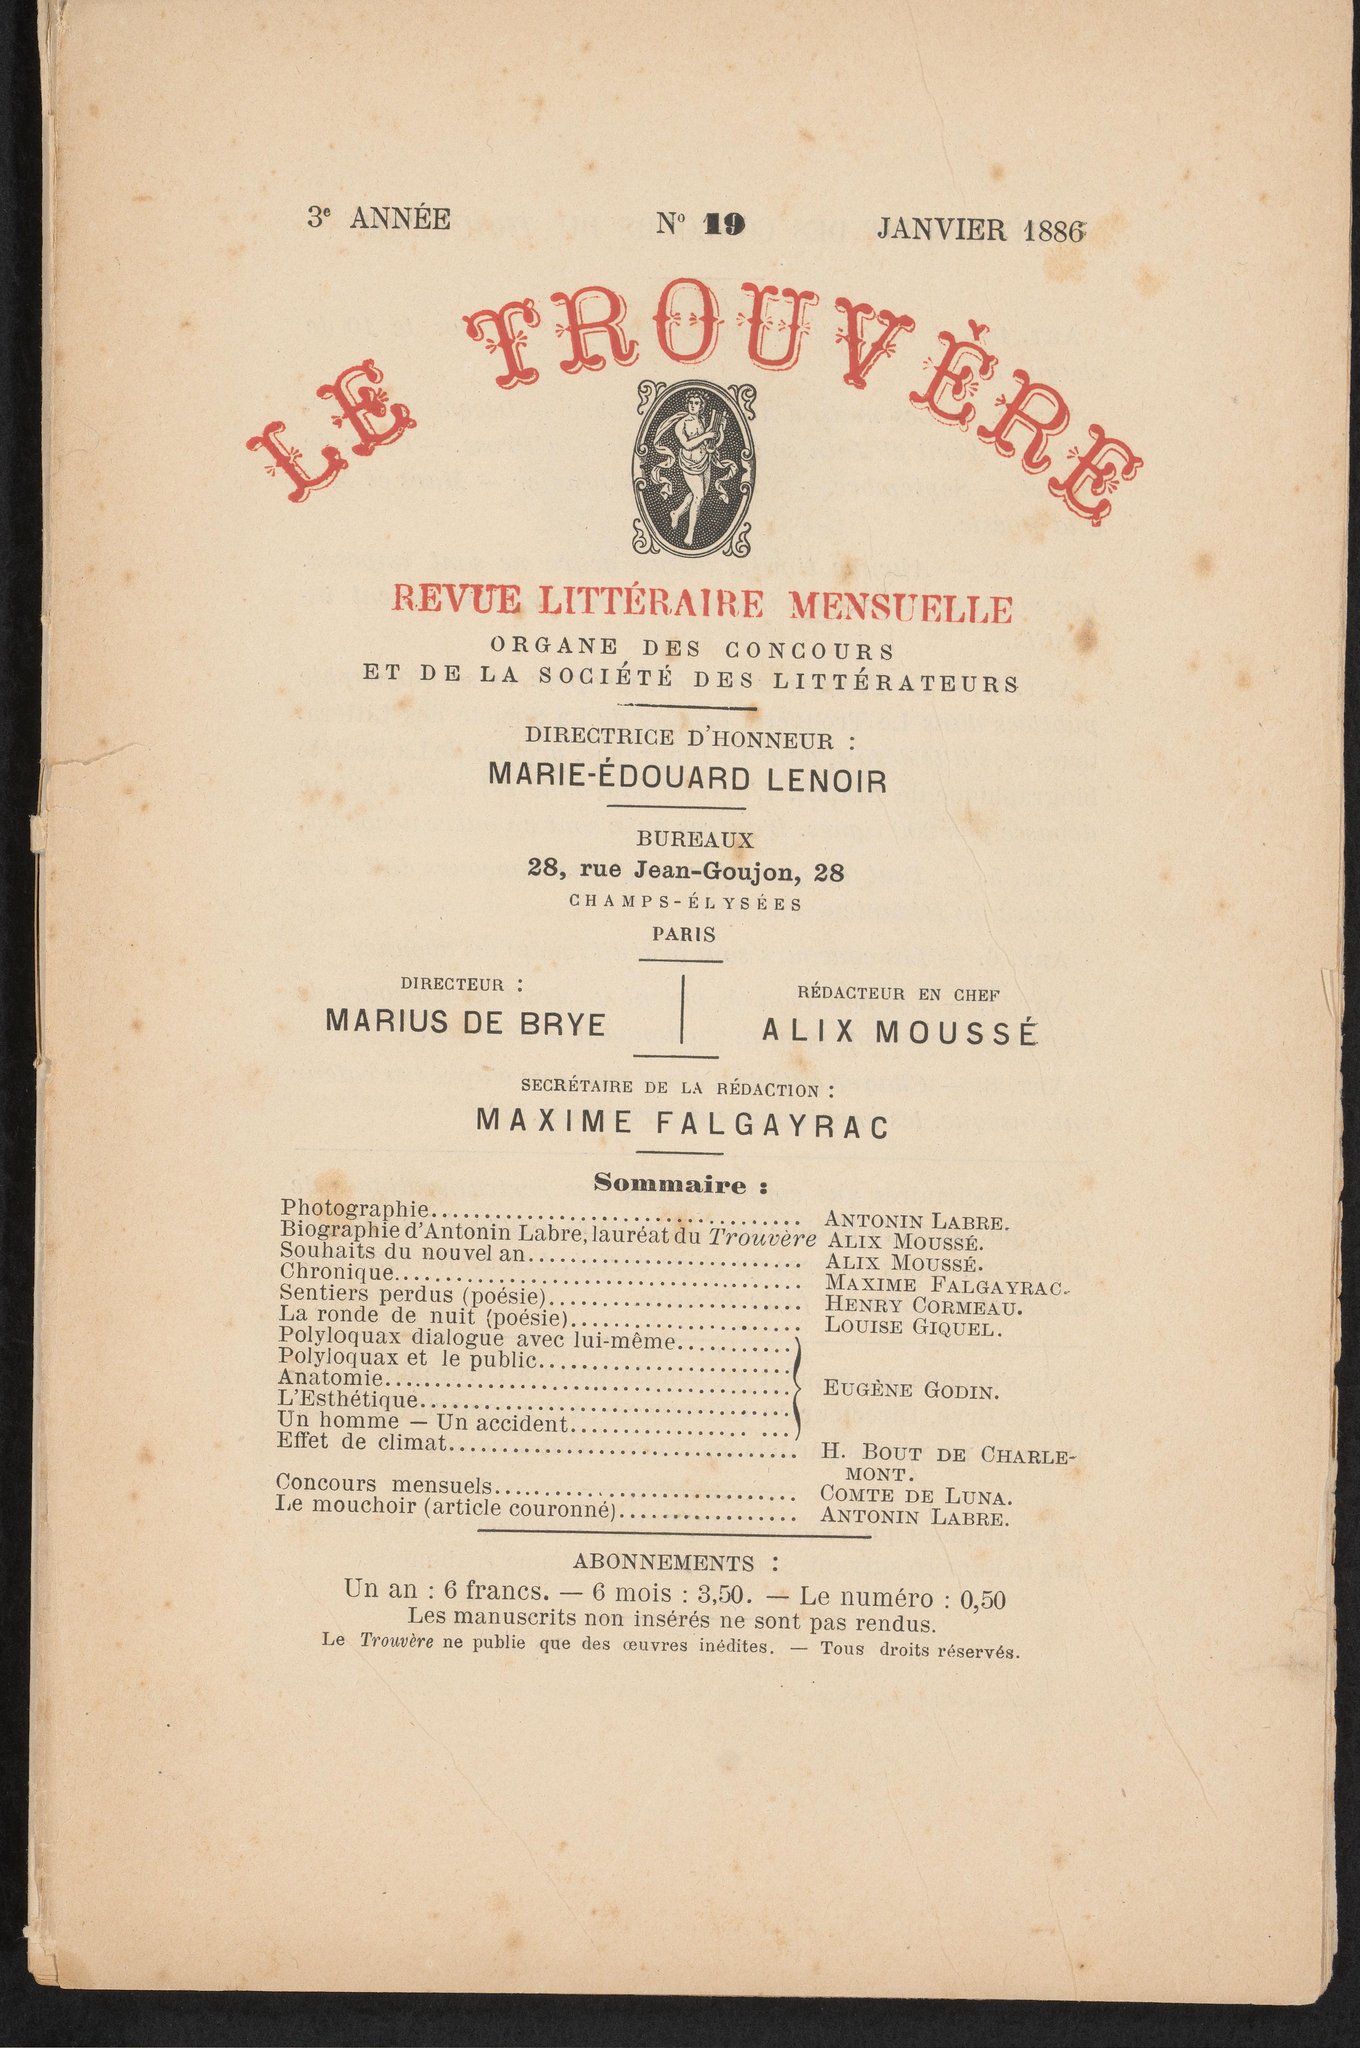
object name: book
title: Le trouvère No 19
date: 1801-1886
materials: paper, photographic support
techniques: albumen print, printing, engraving